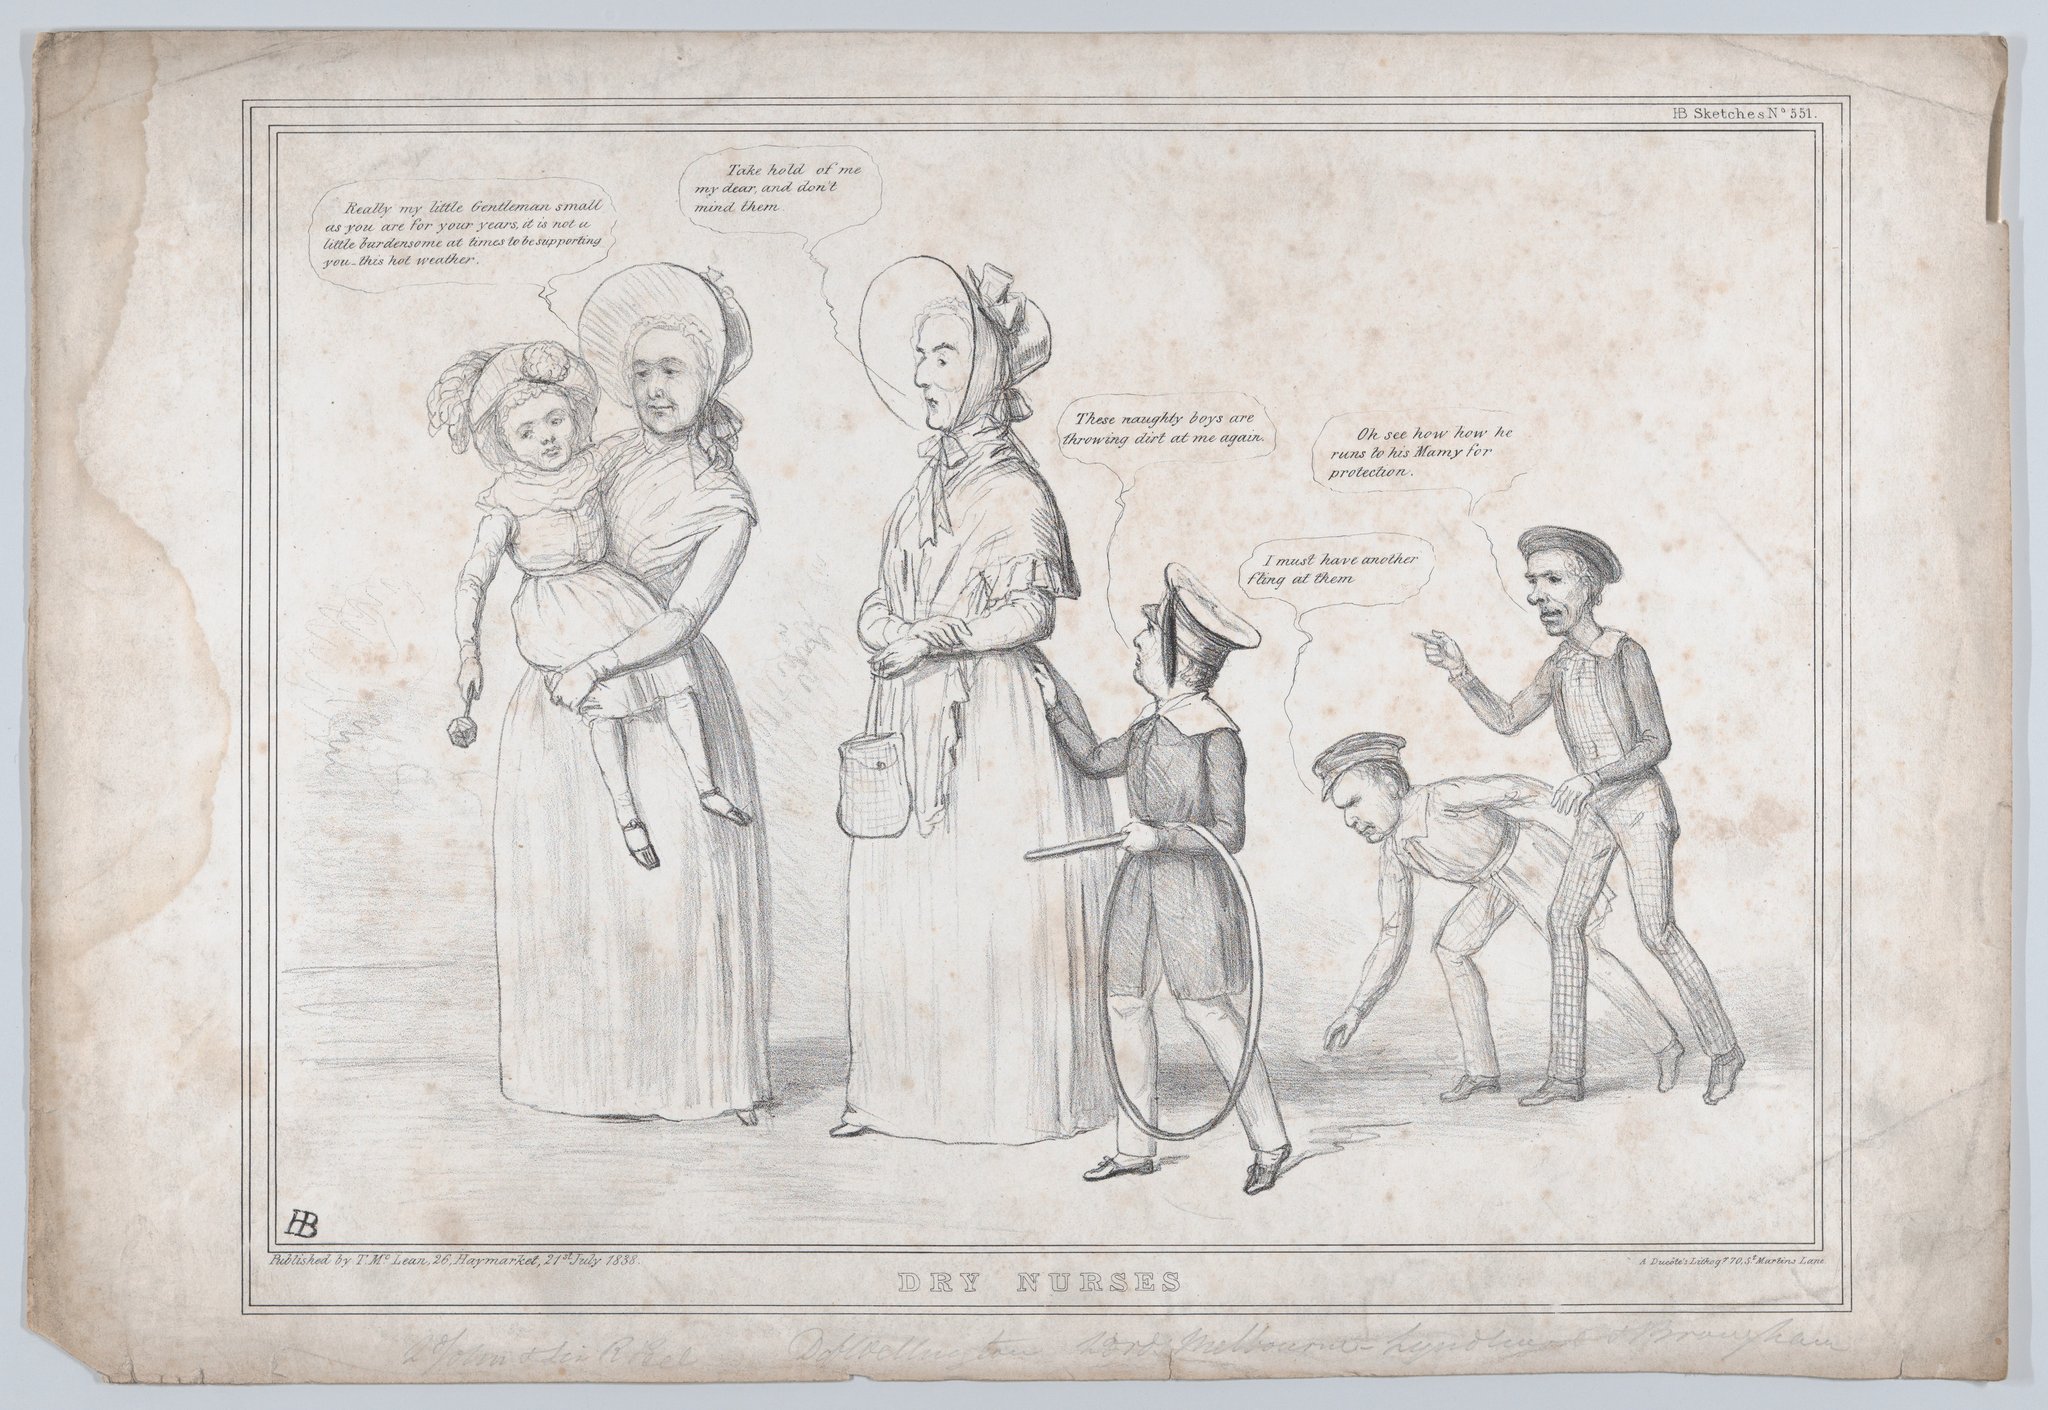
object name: print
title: Dry Nurses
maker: john doyle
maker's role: artist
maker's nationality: irish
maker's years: 1797-1868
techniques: lithograph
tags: boys,girls,women